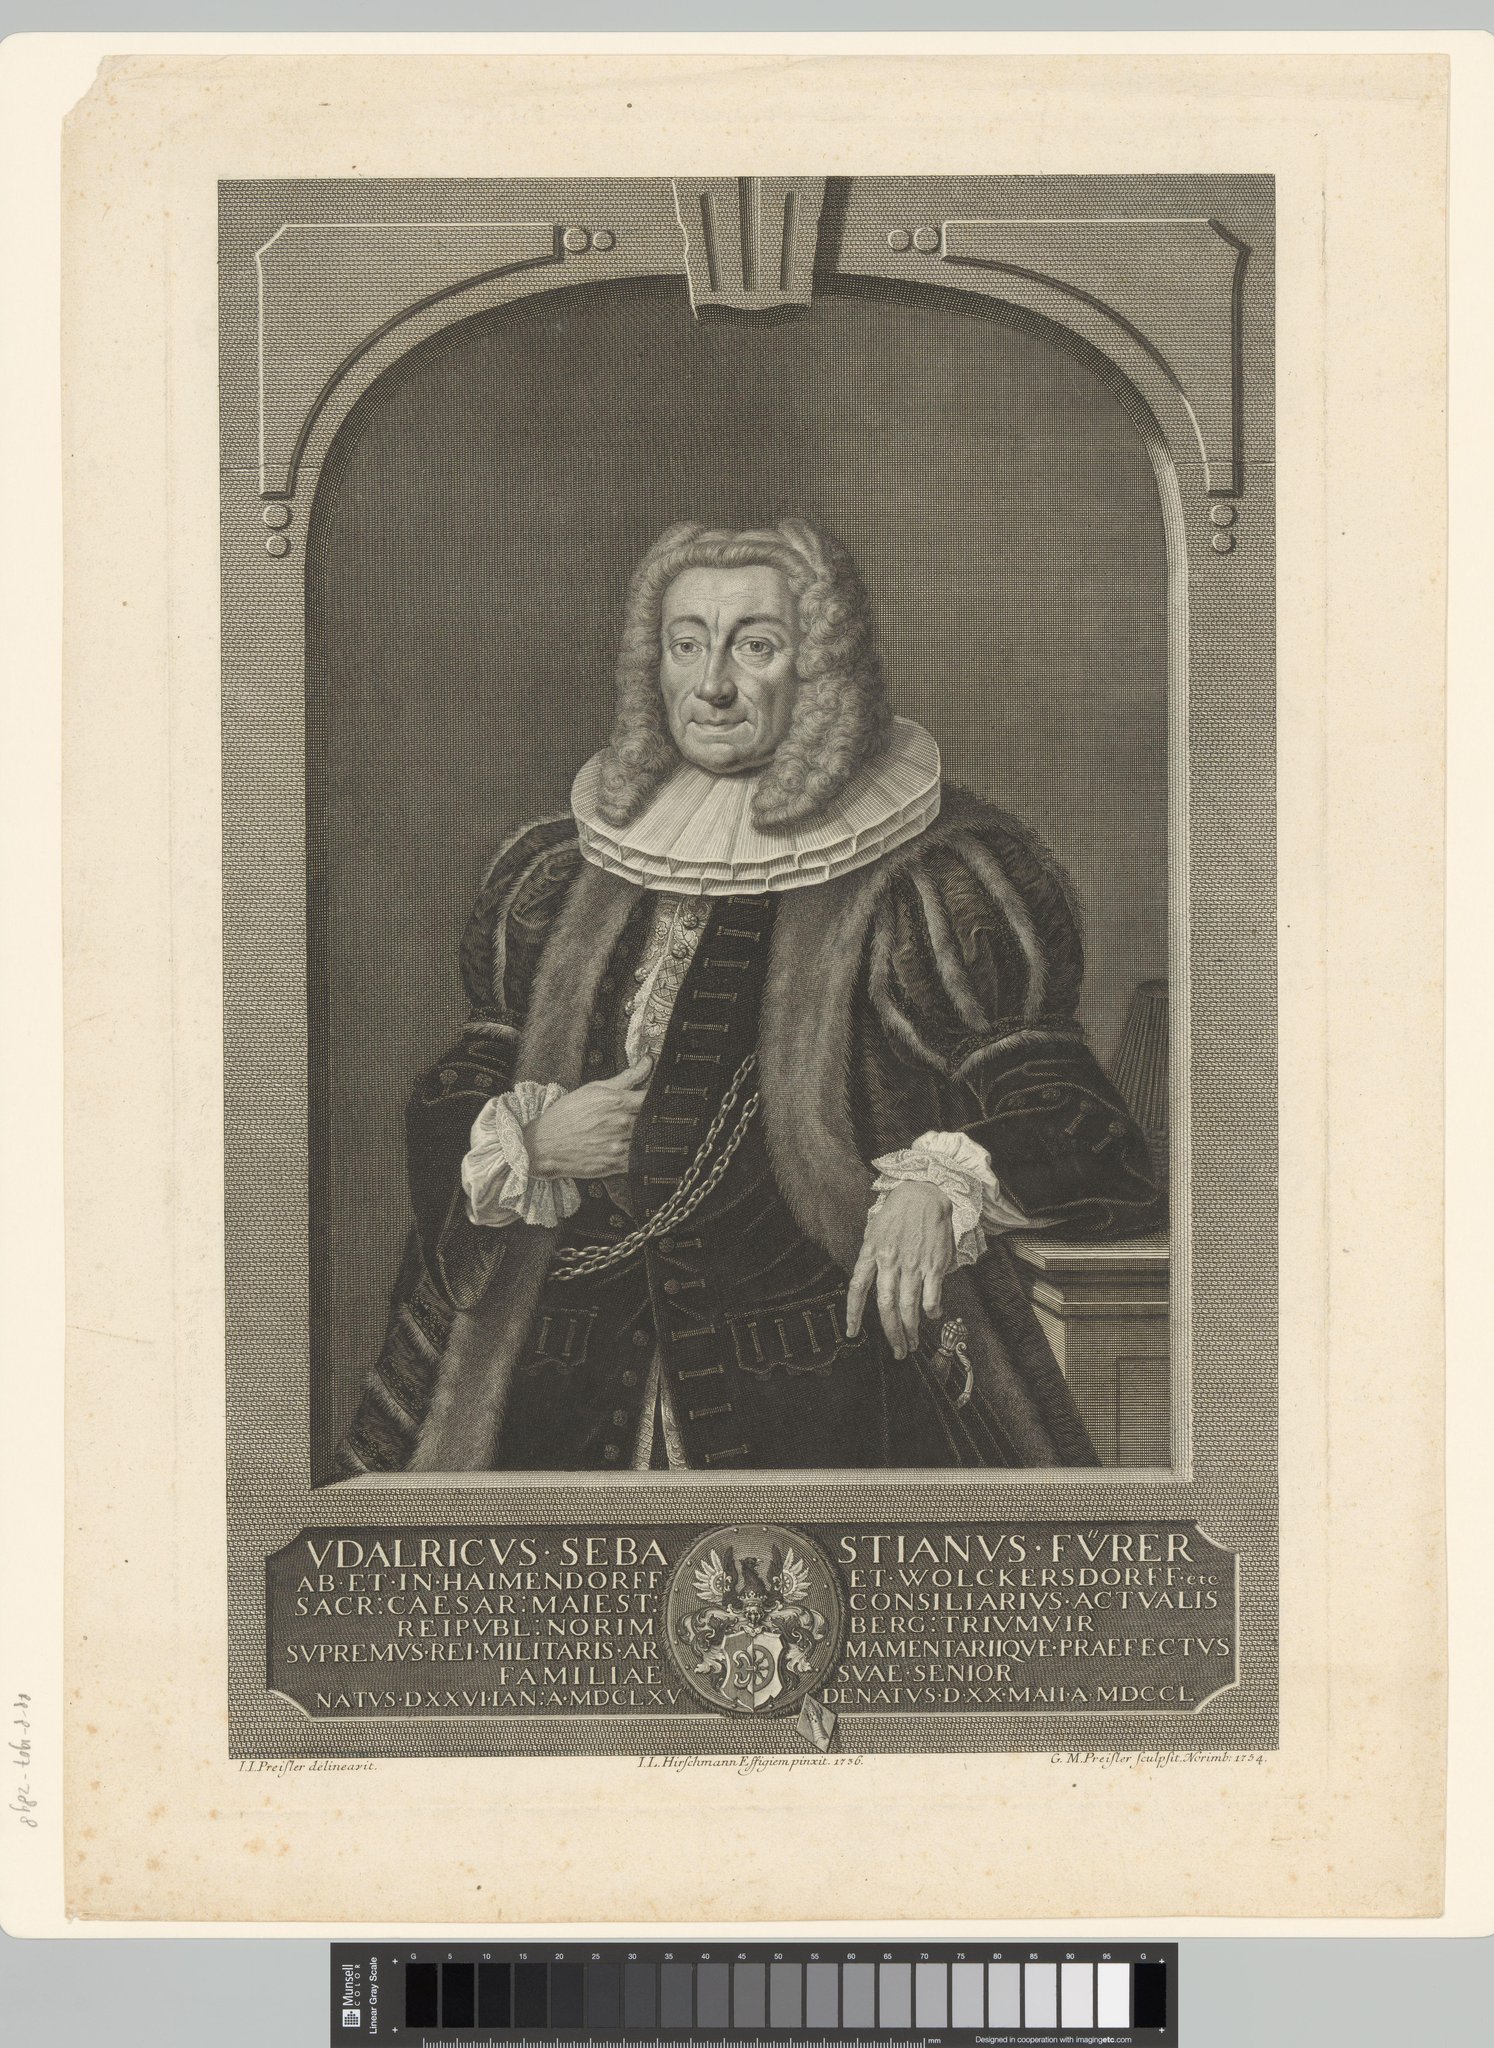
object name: print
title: Portret van Ulrich Sebastian Fürer von Haimendorf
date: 1754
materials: paper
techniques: engraving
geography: nuremberg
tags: other non-personal regalia, e.g. mayor chain, historical persons, hacking and thrusting weapons: sword, armorial bearing, heraldry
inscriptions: collector's mark: Lugt 2228, collector's mark: Lugt 1496c